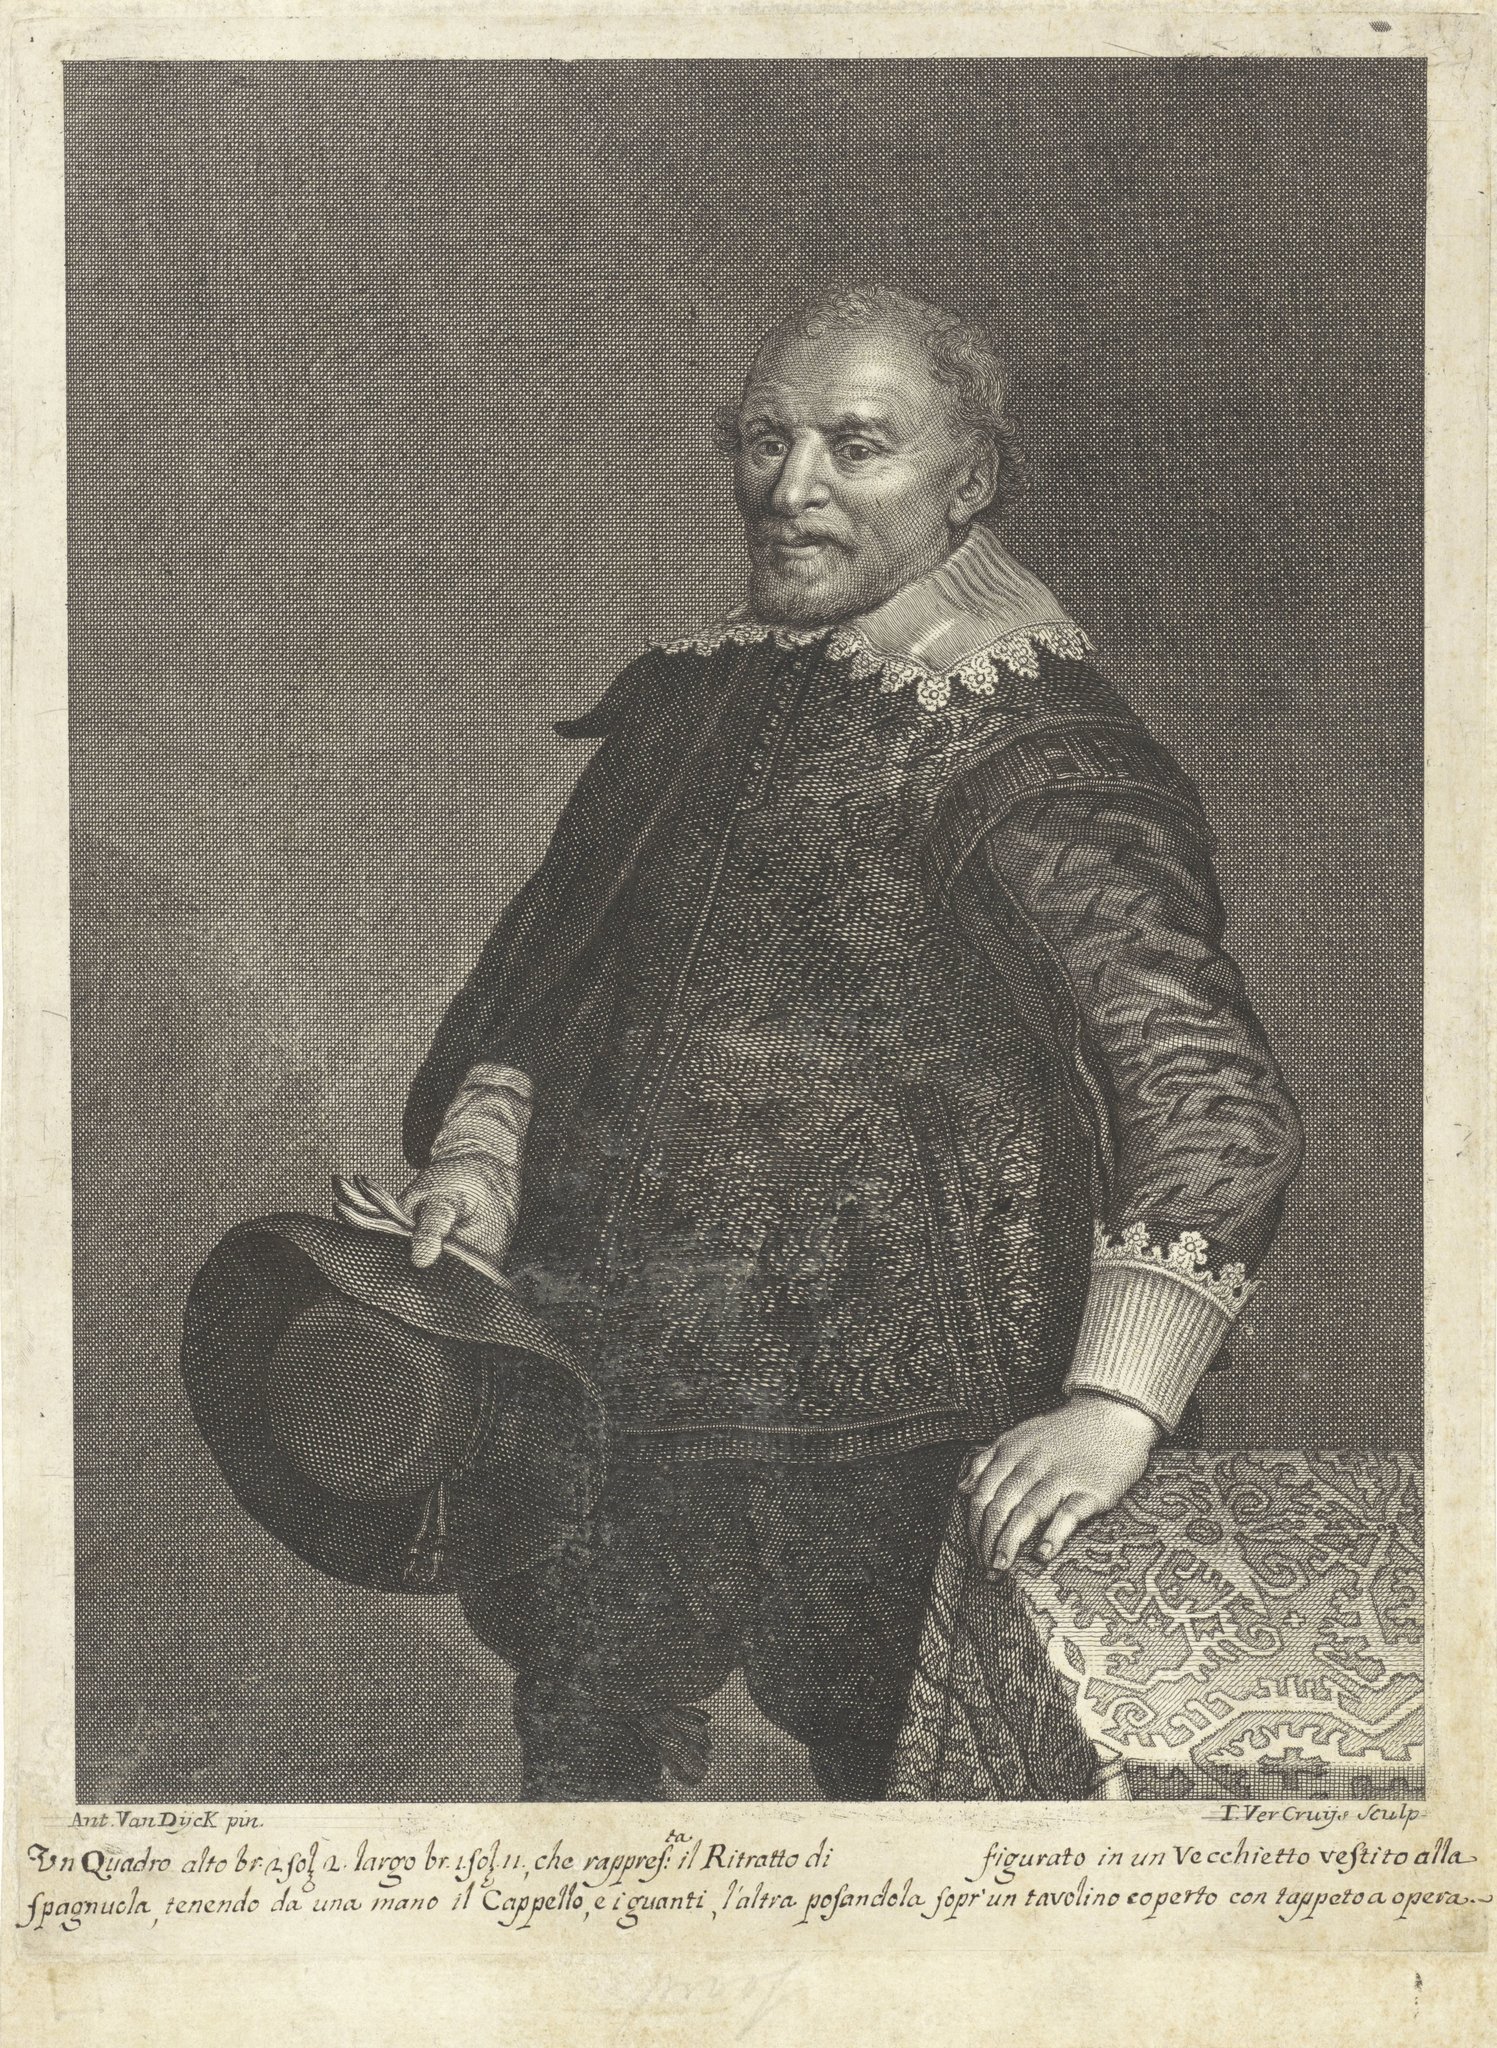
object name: print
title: Portret van een onbekende man, hoed in de hand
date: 1690-1739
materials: paper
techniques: engraving, etching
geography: italy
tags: adult man, head-gear: hat (+ men's clothes)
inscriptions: inscription: ‘twee regels in het Italiaans’, collector's mark: Lugt 2228, collector's mark: Lugt 2364